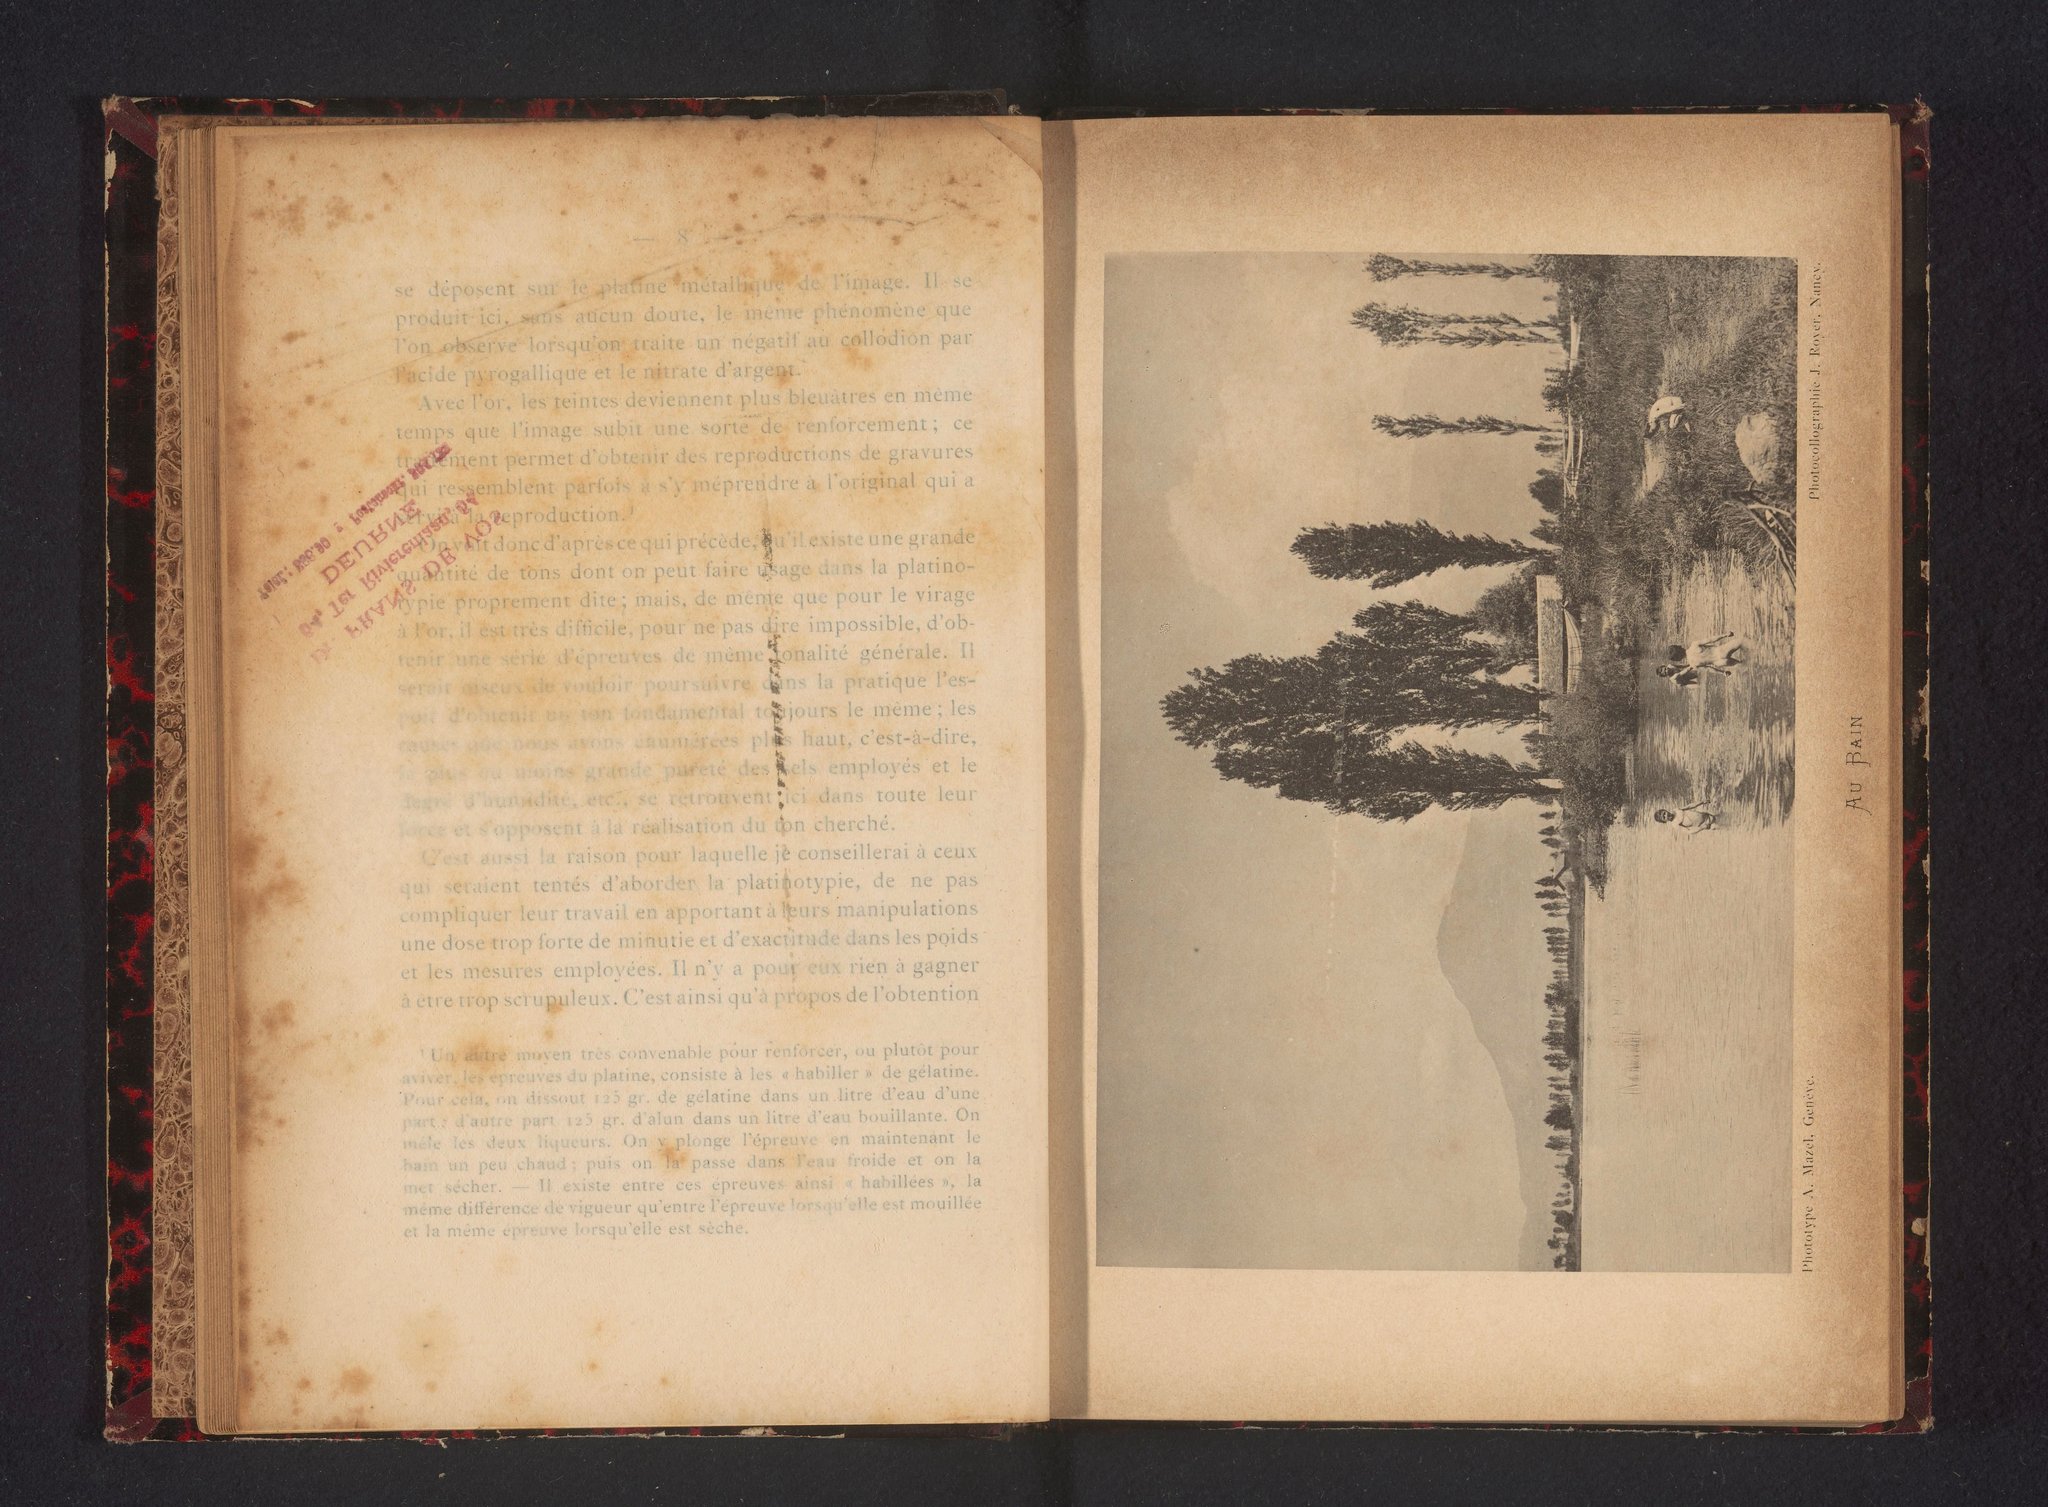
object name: page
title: Au Bain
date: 1893-1898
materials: paper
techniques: photograph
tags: boy (child between toddler and youth), lake